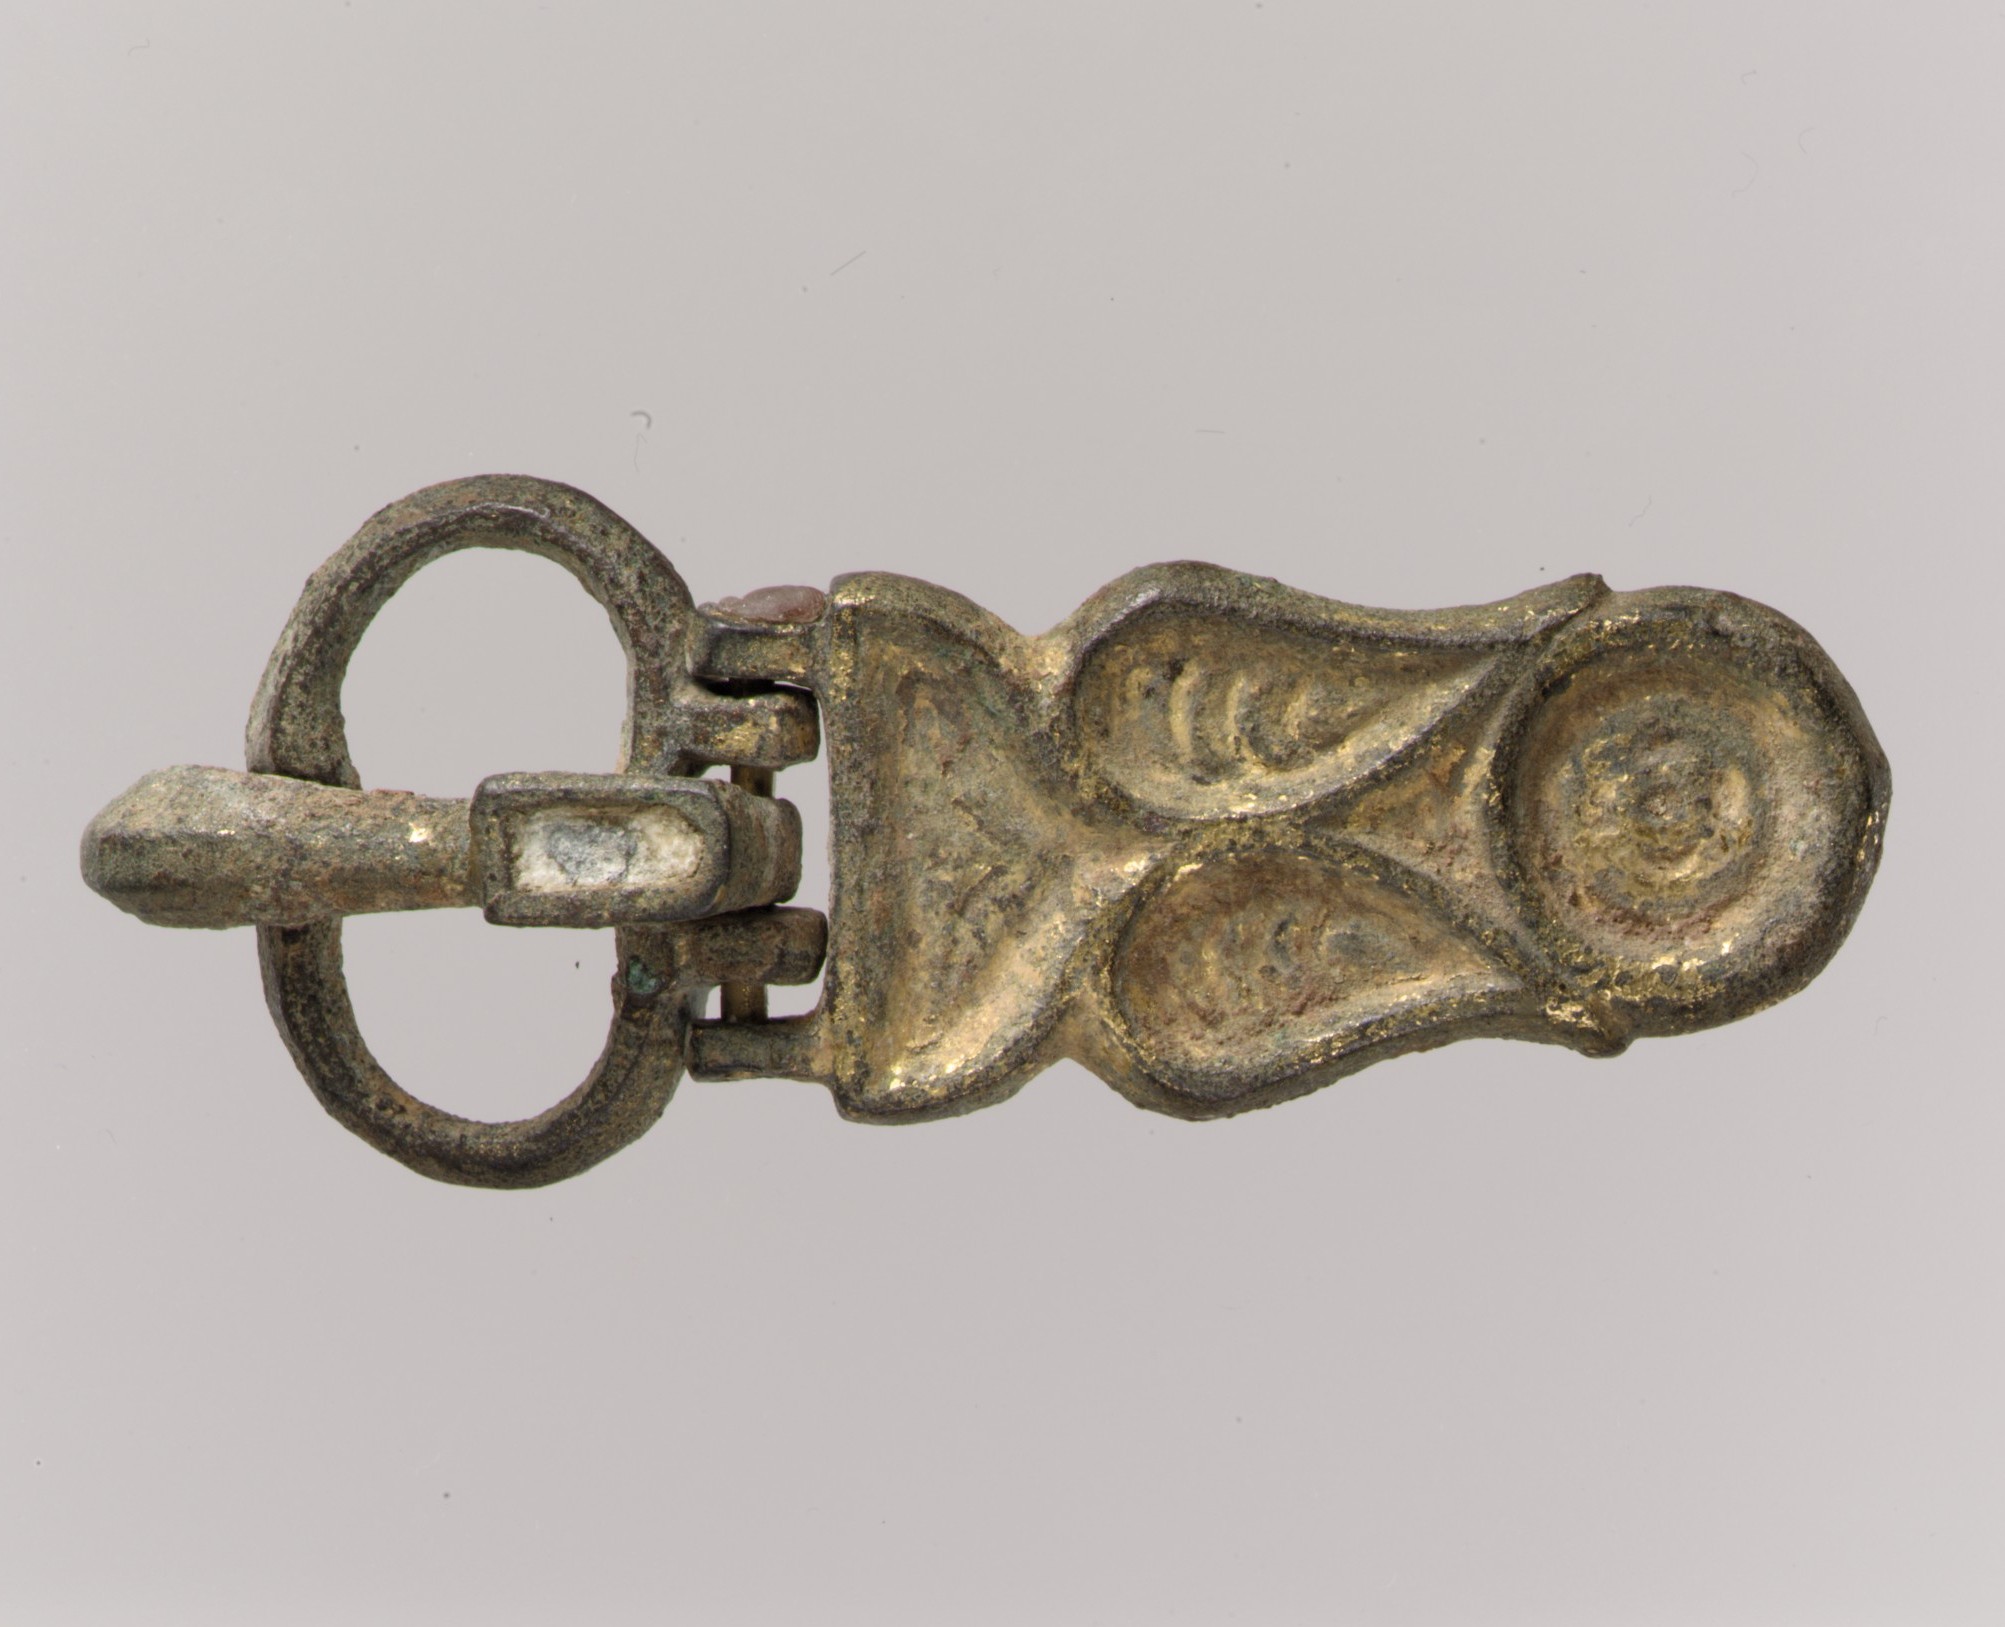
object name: belt buckle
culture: east mediterranean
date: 601-700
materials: copper alloy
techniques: gilding